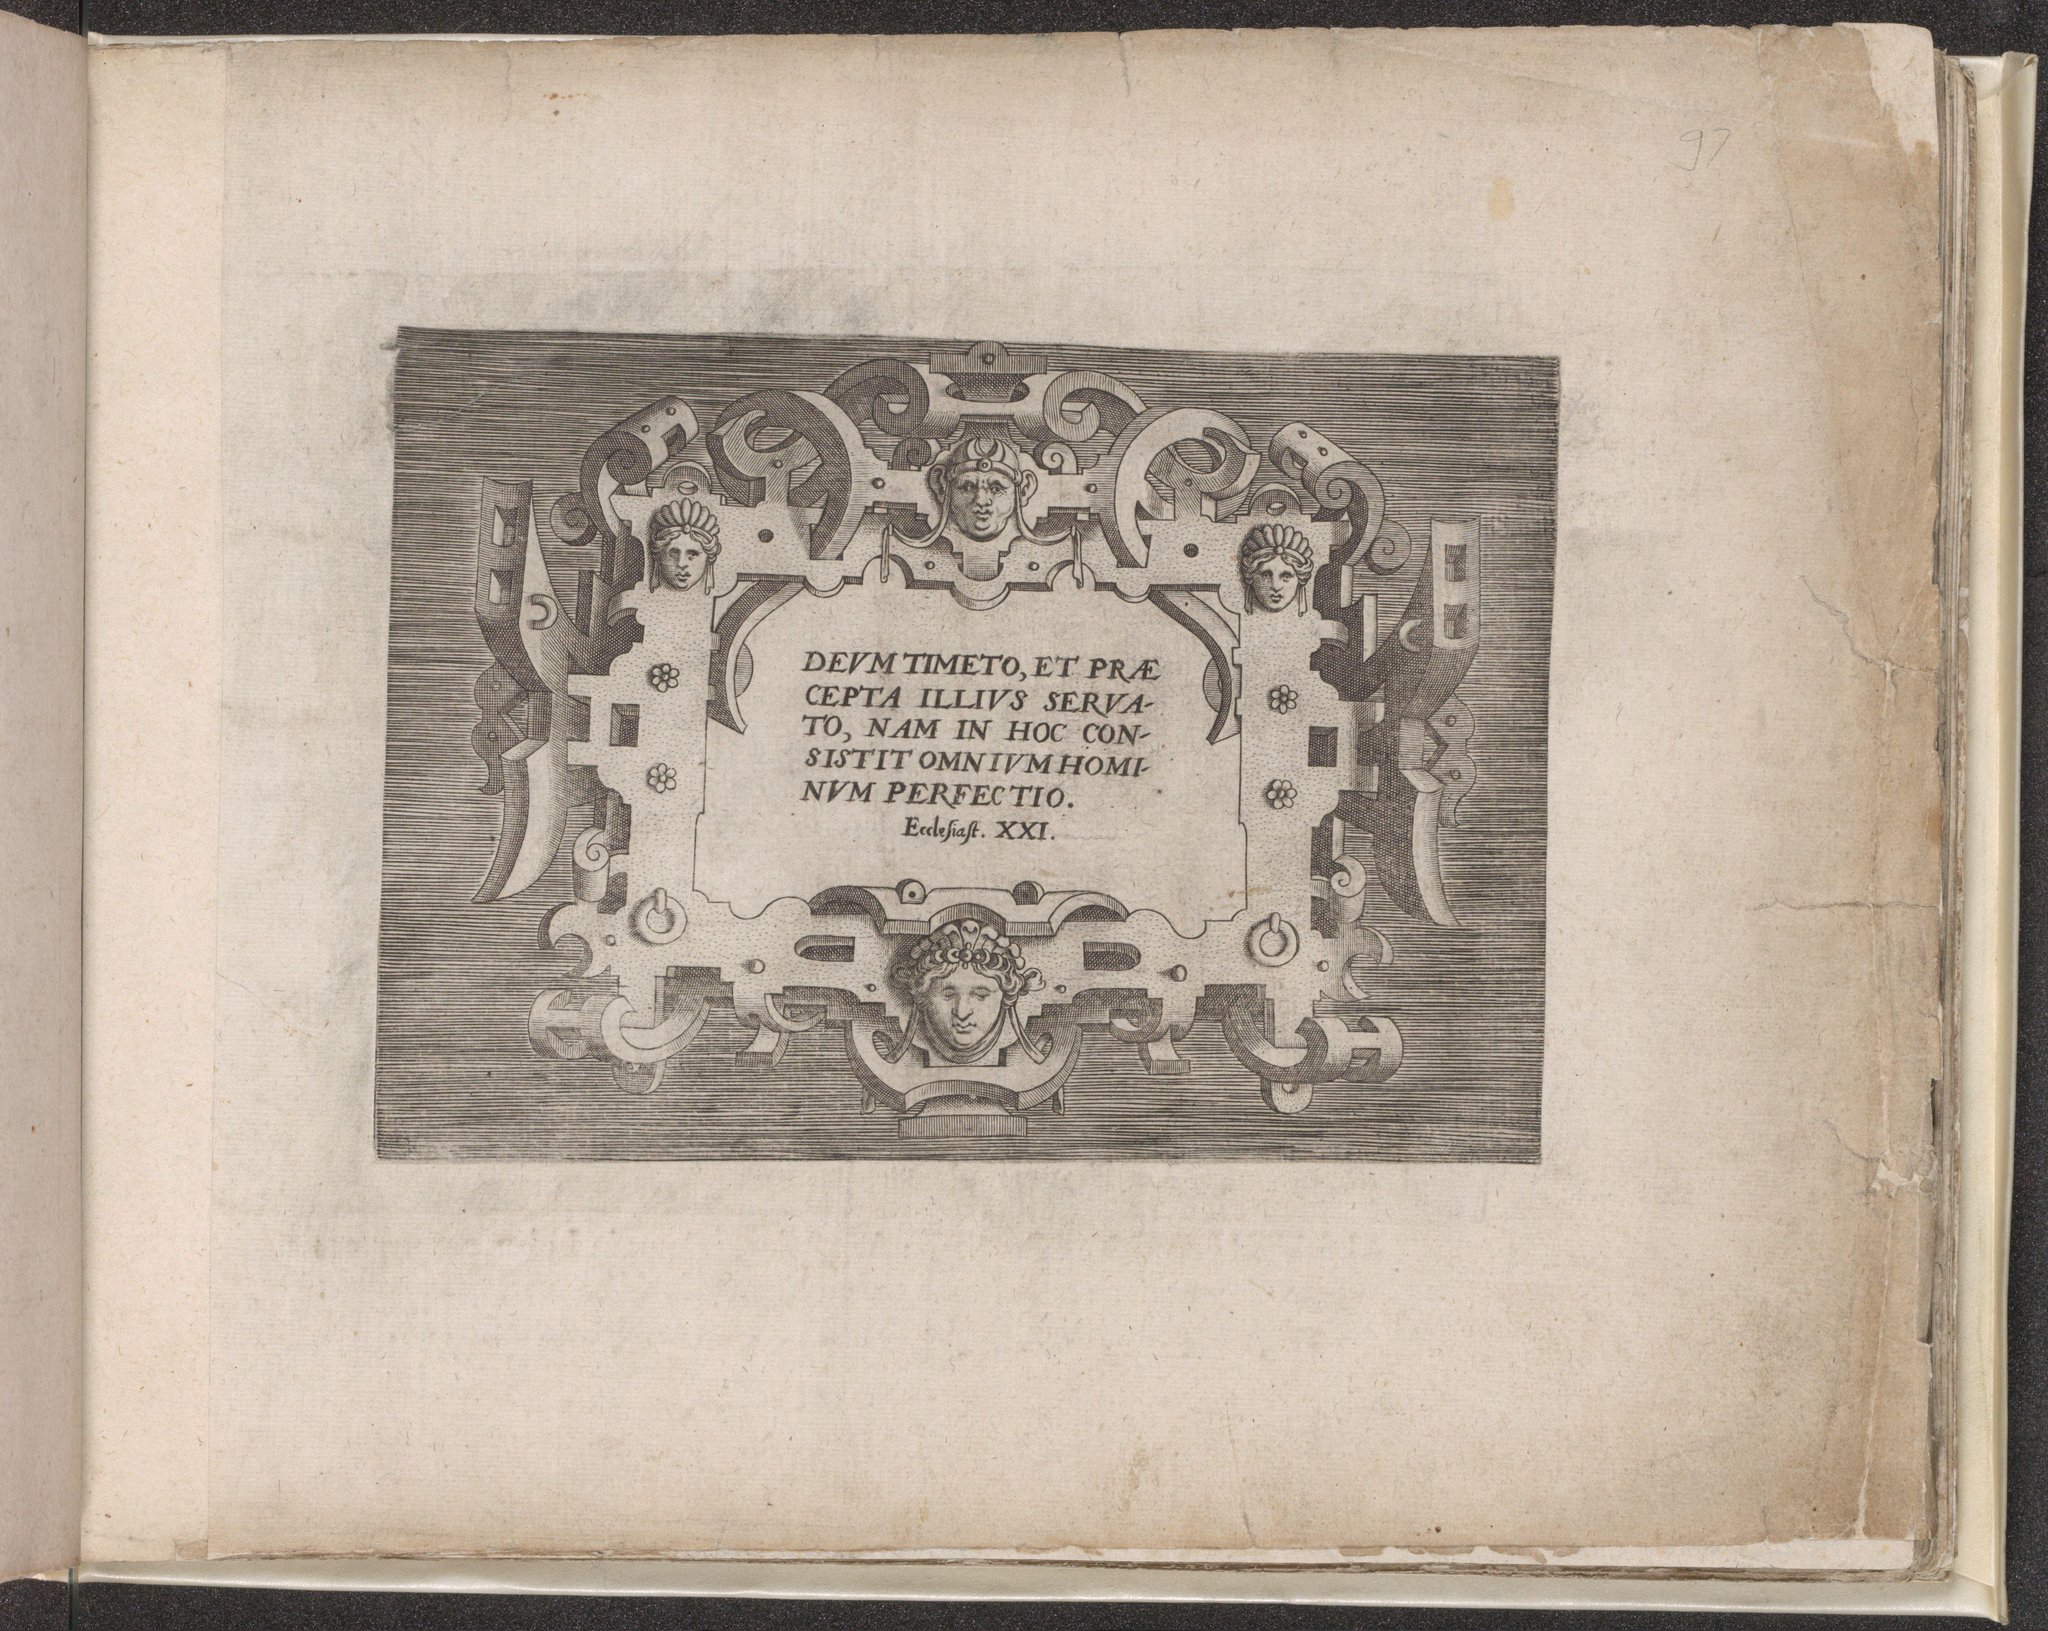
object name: print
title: Cartouche met een tekst uit het Bijbelboek Prediker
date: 1555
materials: paper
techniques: engraving, etching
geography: antwerp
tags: ornament ~ cartouche, mask, mascaron ~ ornament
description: Cartouche met een tekst uit Pr. 12:13 in het Latijn. Ornament met bovenaan drie maskers en midden onder een masker. Deze prent maakt deel uit van een album.